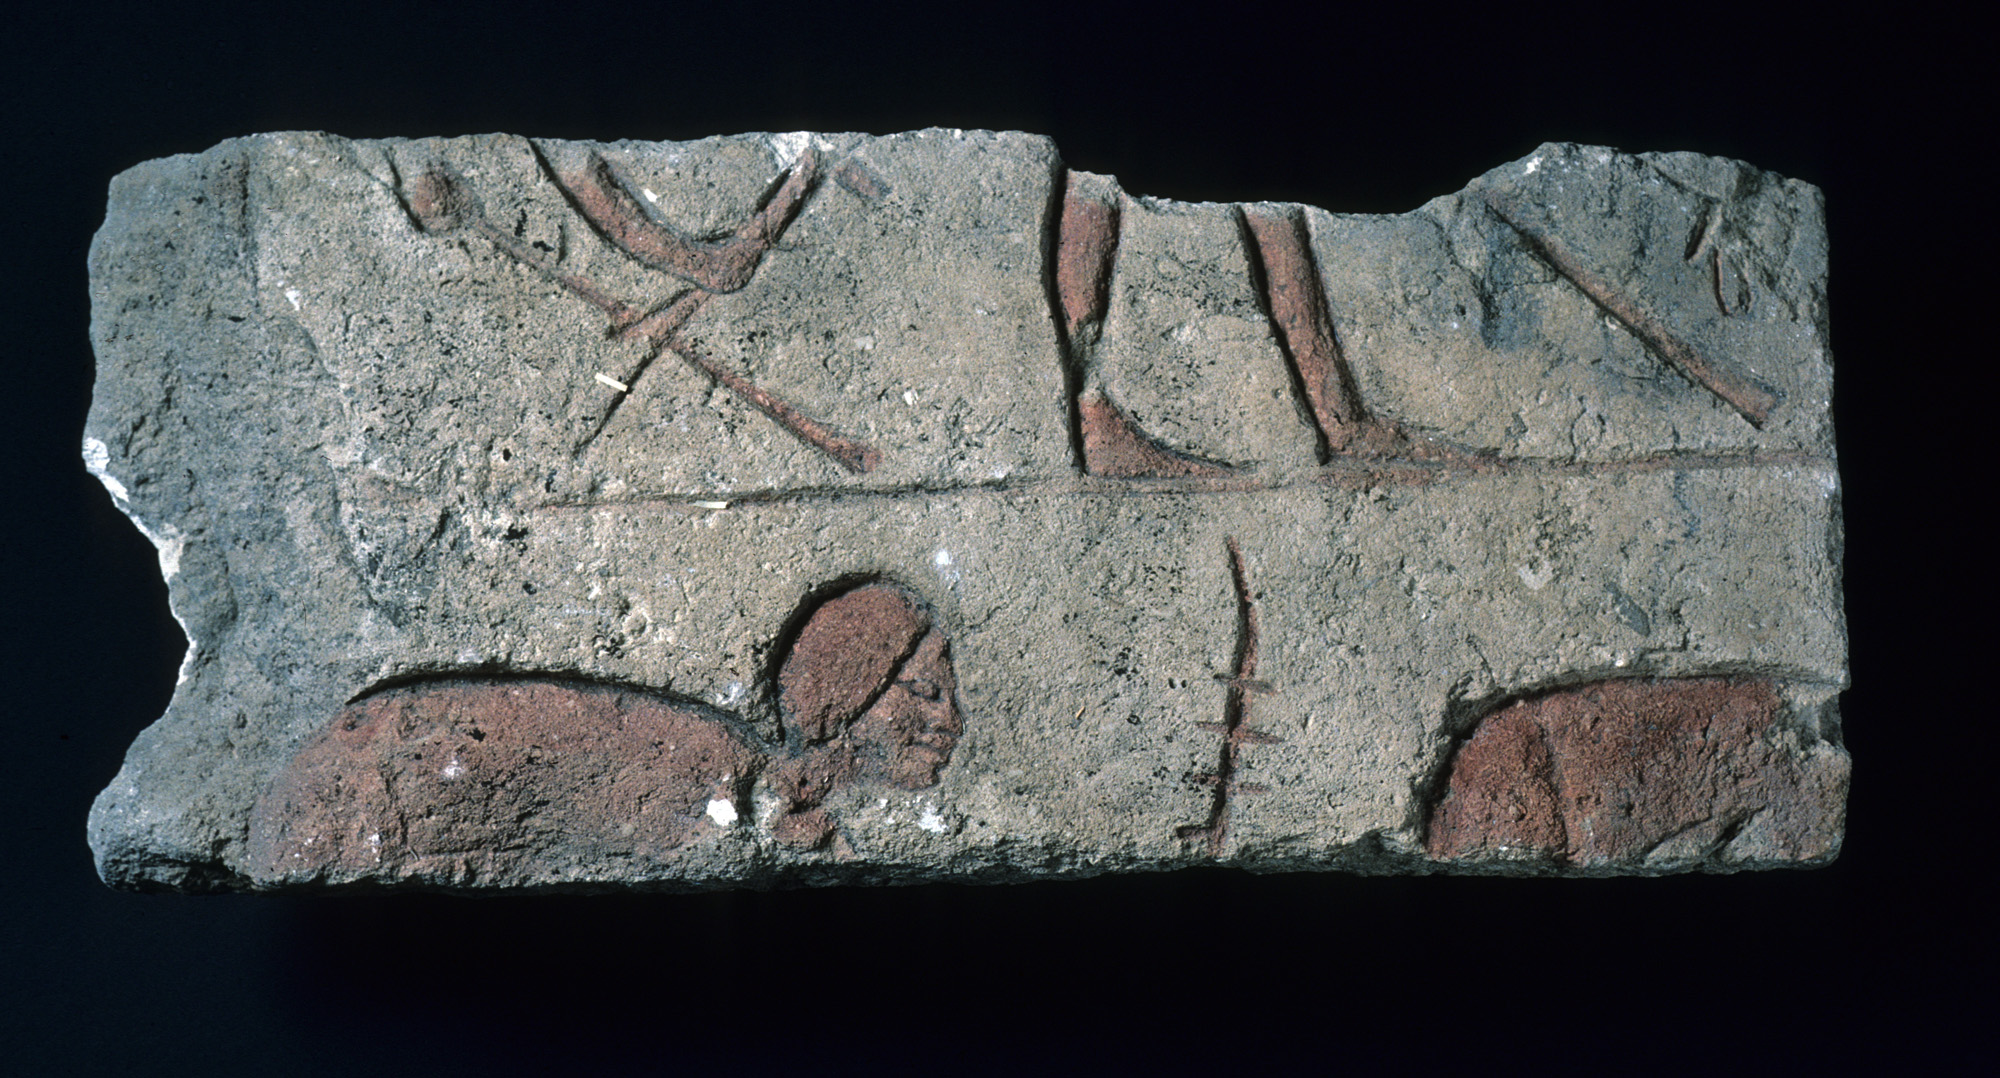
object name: talatat, nubian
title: Relief faragment with Nubians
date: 1353-1336 BCE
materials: limestone, paint